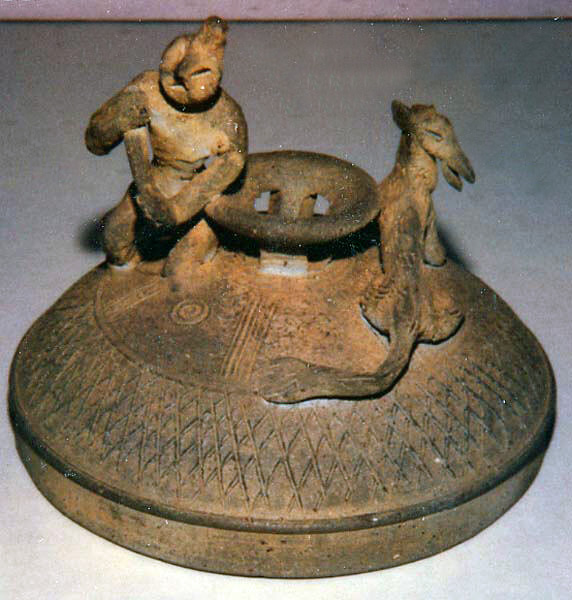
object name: lid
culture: korean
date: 401-700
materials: pottery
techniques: firing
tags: animals,men